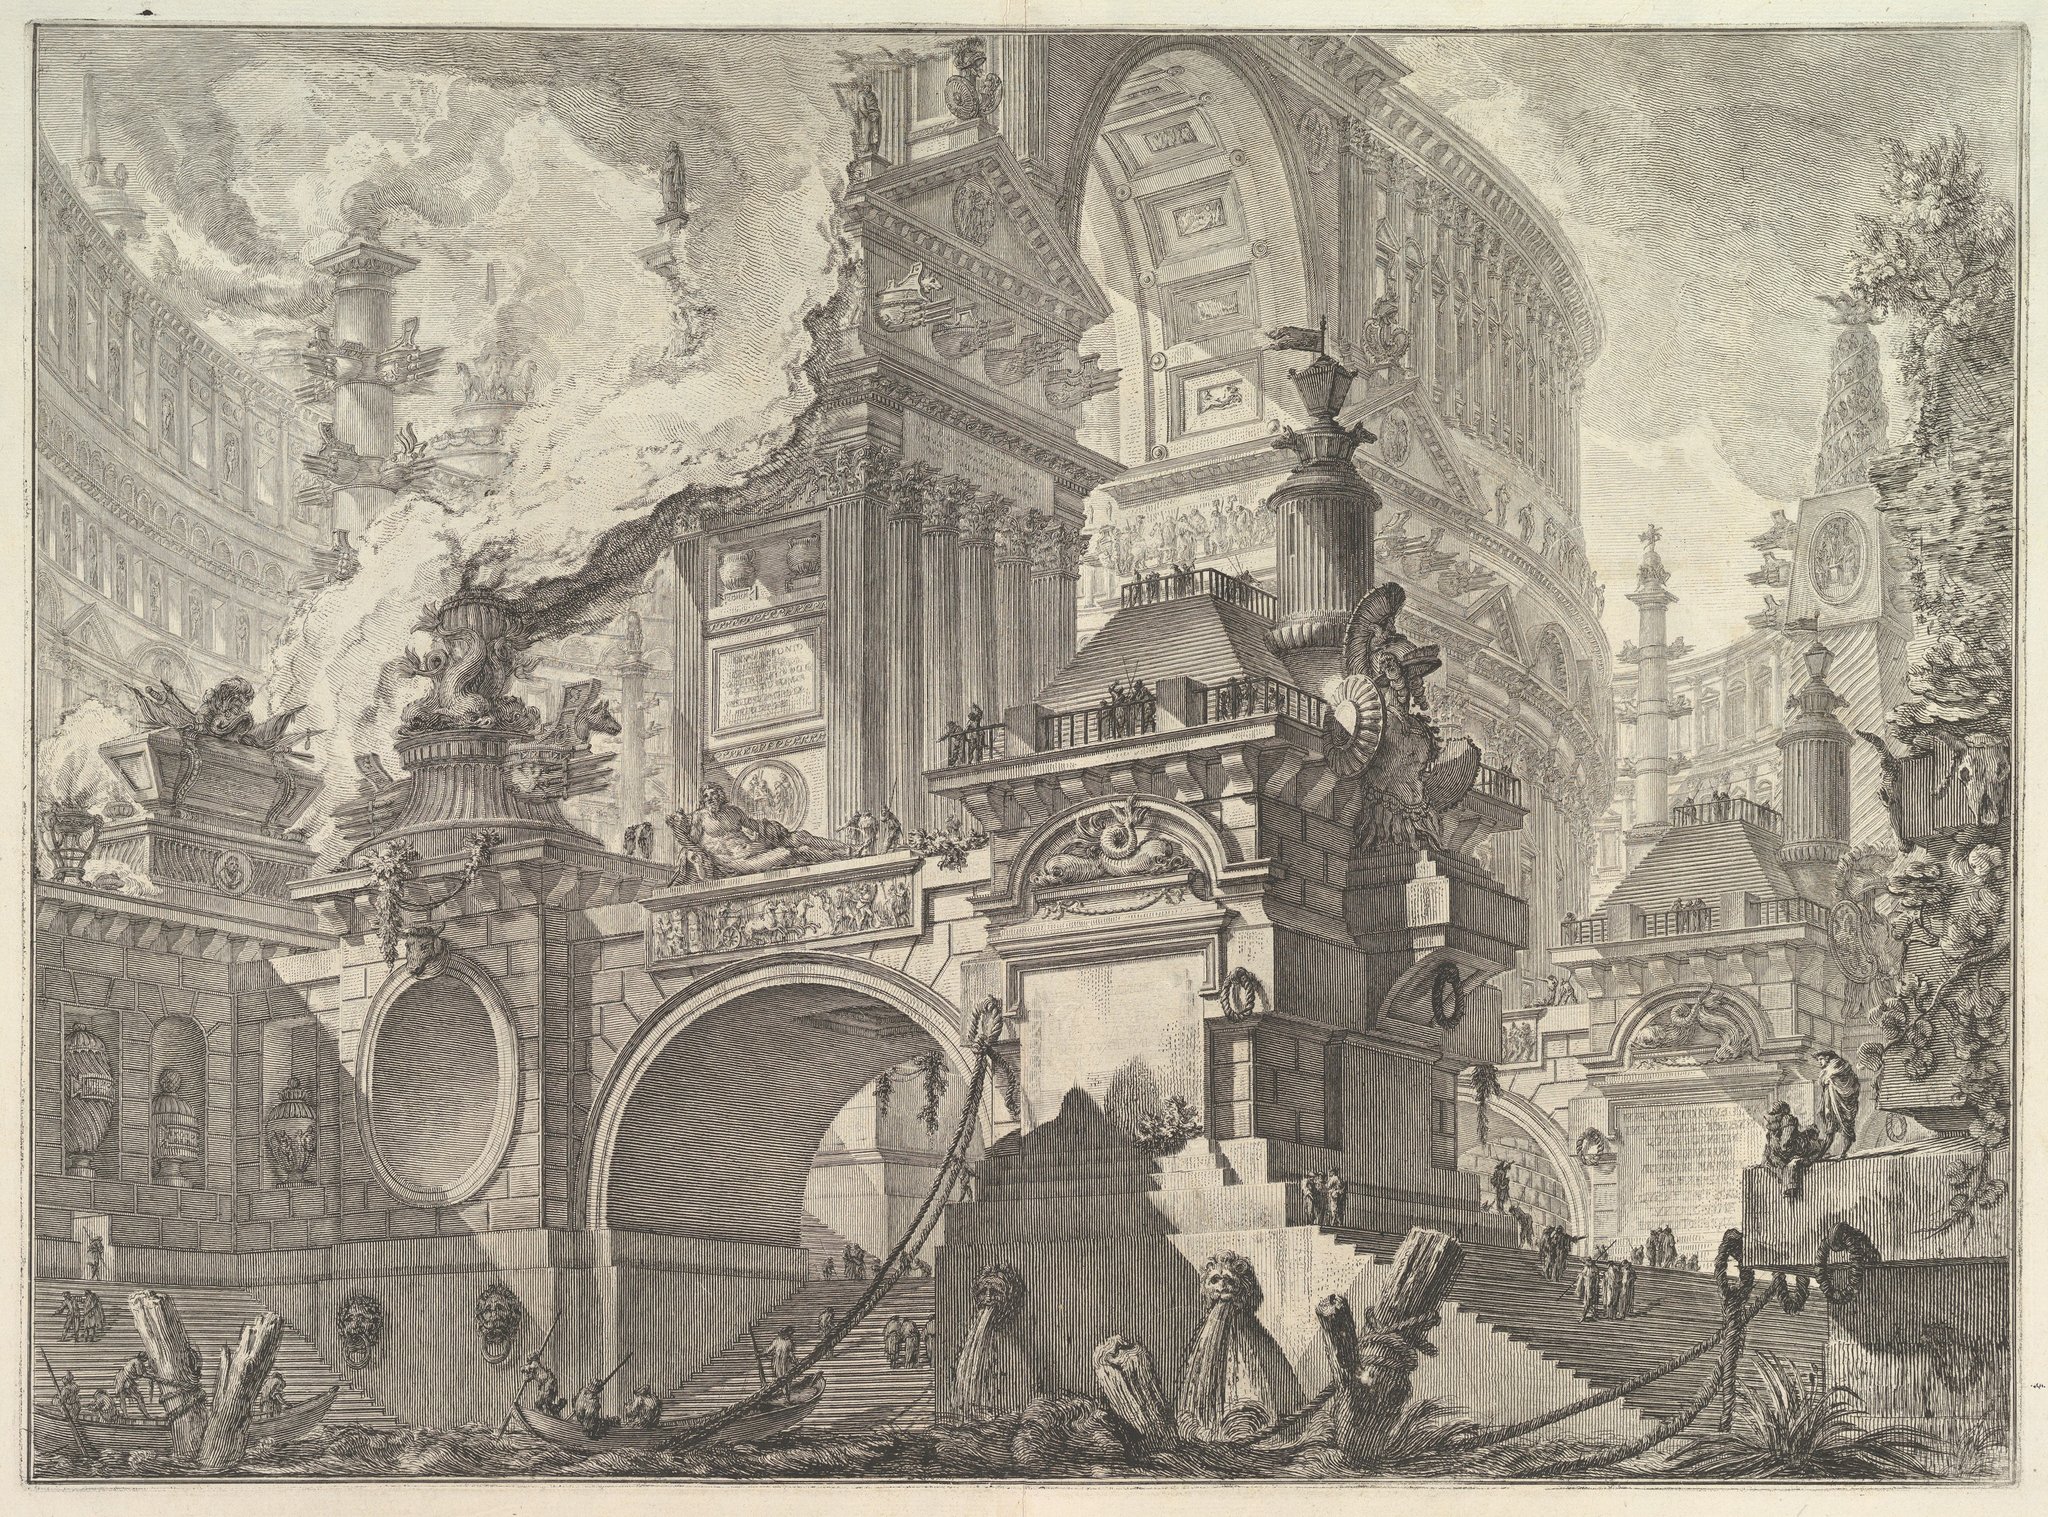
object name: print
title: Parte di ampio magnifico Porto all'uso degli antichi Romani, ove si scuopre l'interno della gran Piazza pel Comercio... (Part of a spacious and magnificent Harbor for the use of the ancient Romans opening onto a large market square...), from "Opere Varie di Archiettura, prospettive, grotteschi, antichità; inventate, ed incise da Giambattista Piranesi Architetto Veneziano" (Various Works of Architecture, perspectives, grotesques, and antiquities; designed and etched by Giambattista Piranesi, Venetian Architect)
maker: giovanni battista piranesi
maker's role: artist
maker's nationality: italian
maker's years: 1720-1778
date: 1749-1750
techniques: drypoint, engraving, etching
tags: architecture,arches,ruins,boats